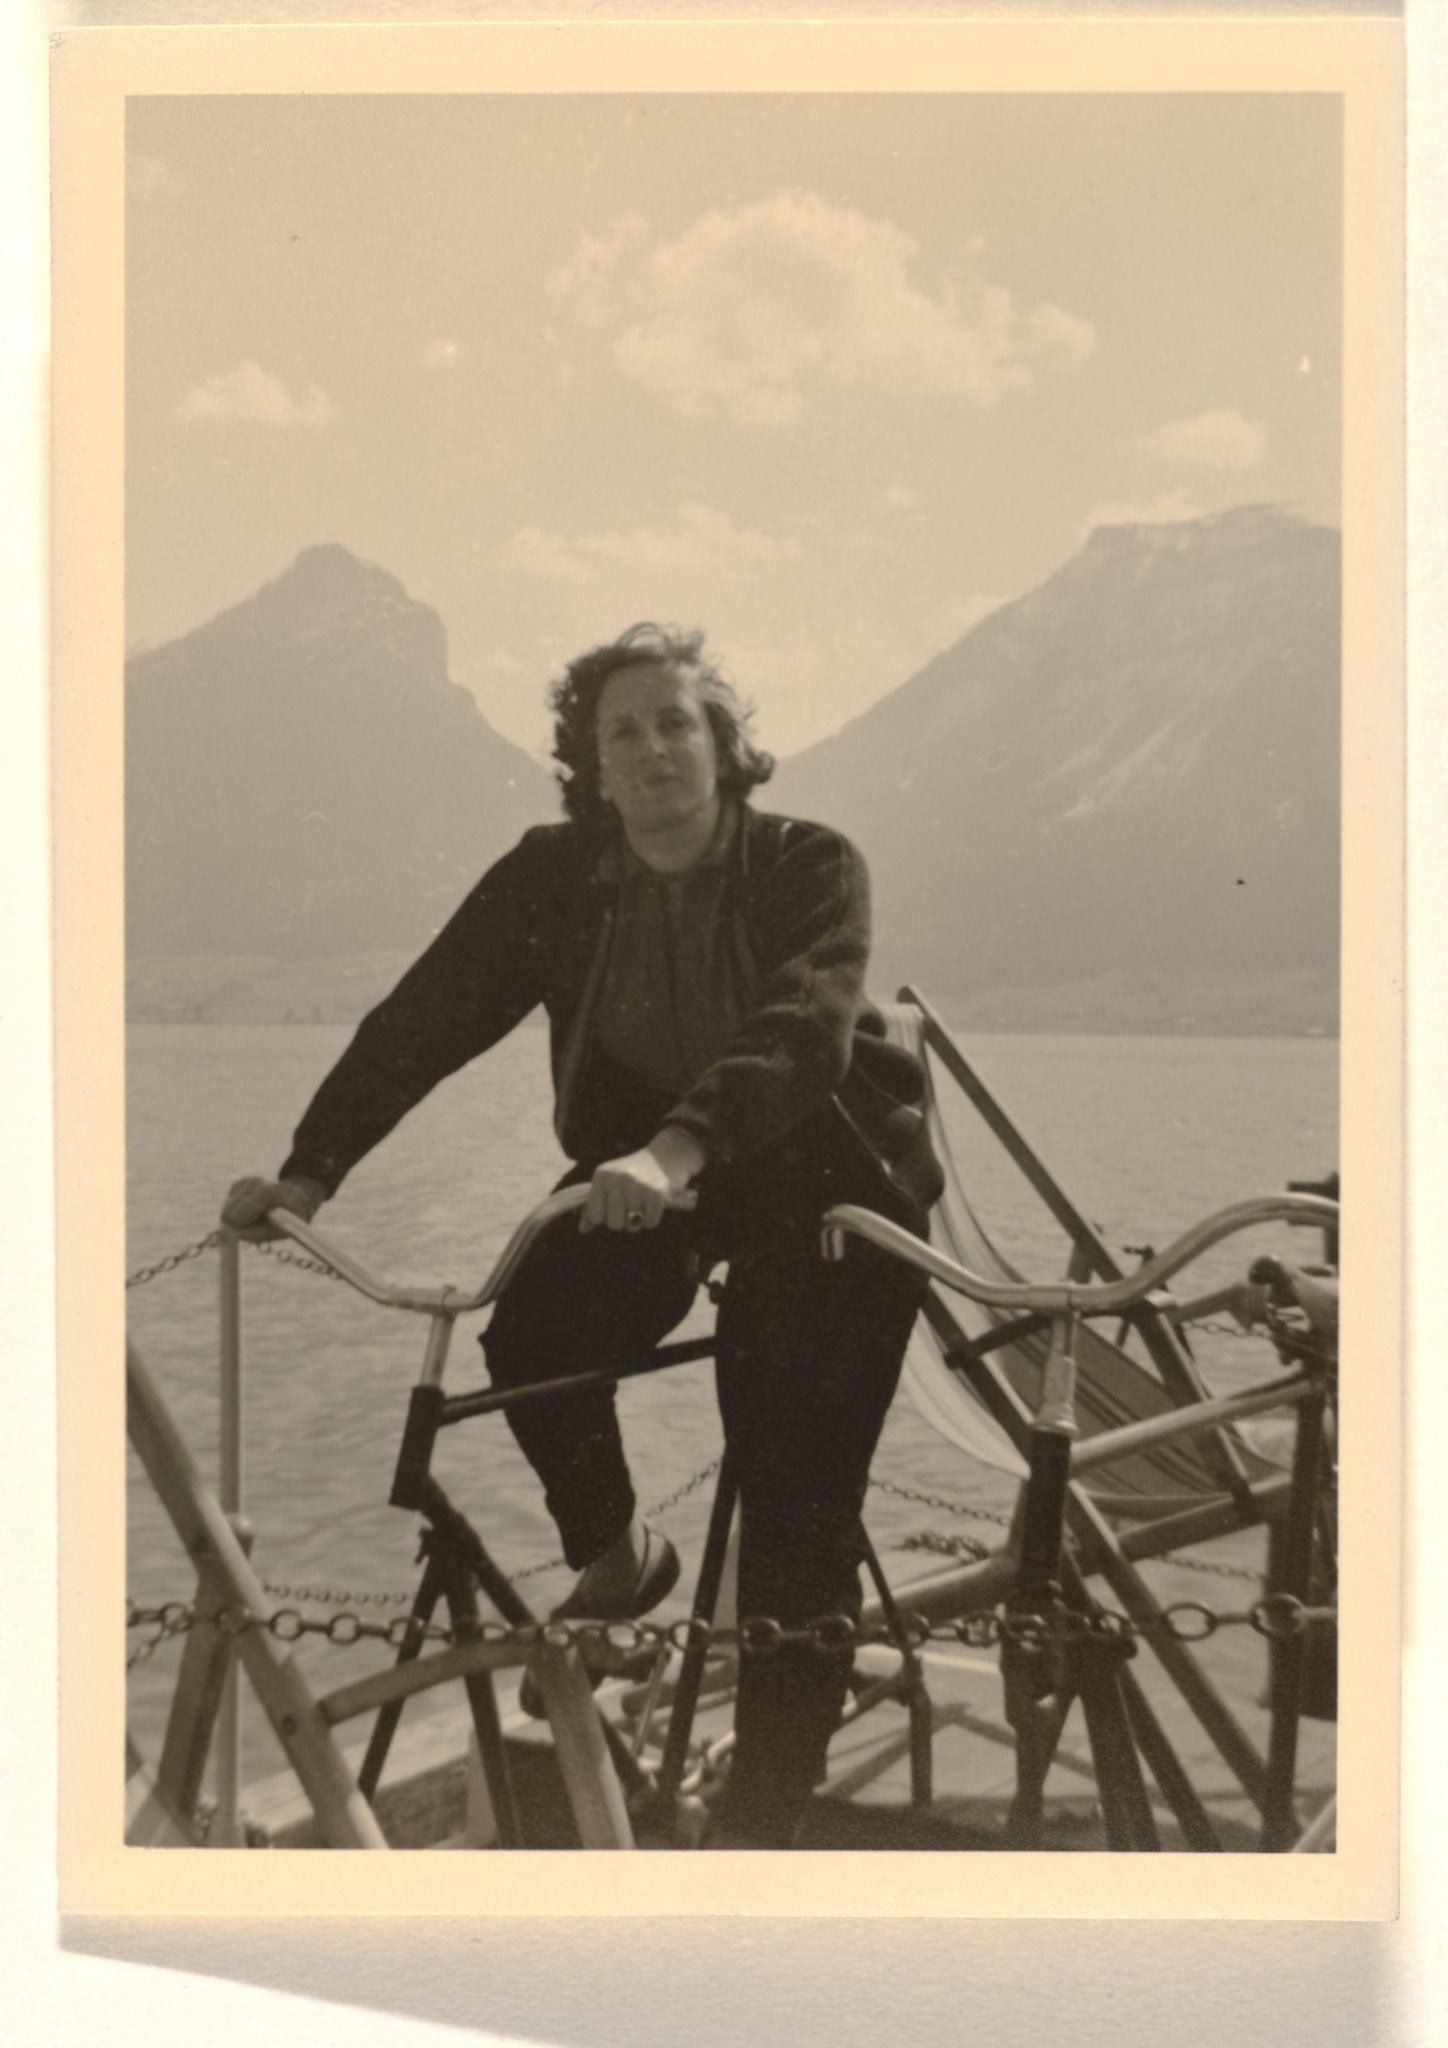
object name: photograph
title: Isabel Wachenheimer gezeten op een fiets voor een meer bij een berg, in donkere kleding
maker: Anonymous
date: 1956-1973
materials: photographic support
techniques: gelatin silver print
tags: leiden, isabel wachenheimer-elon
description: Isabel Wachenheimer gezeten op een fiets voor een meer bij een berg, in donkere kleding.